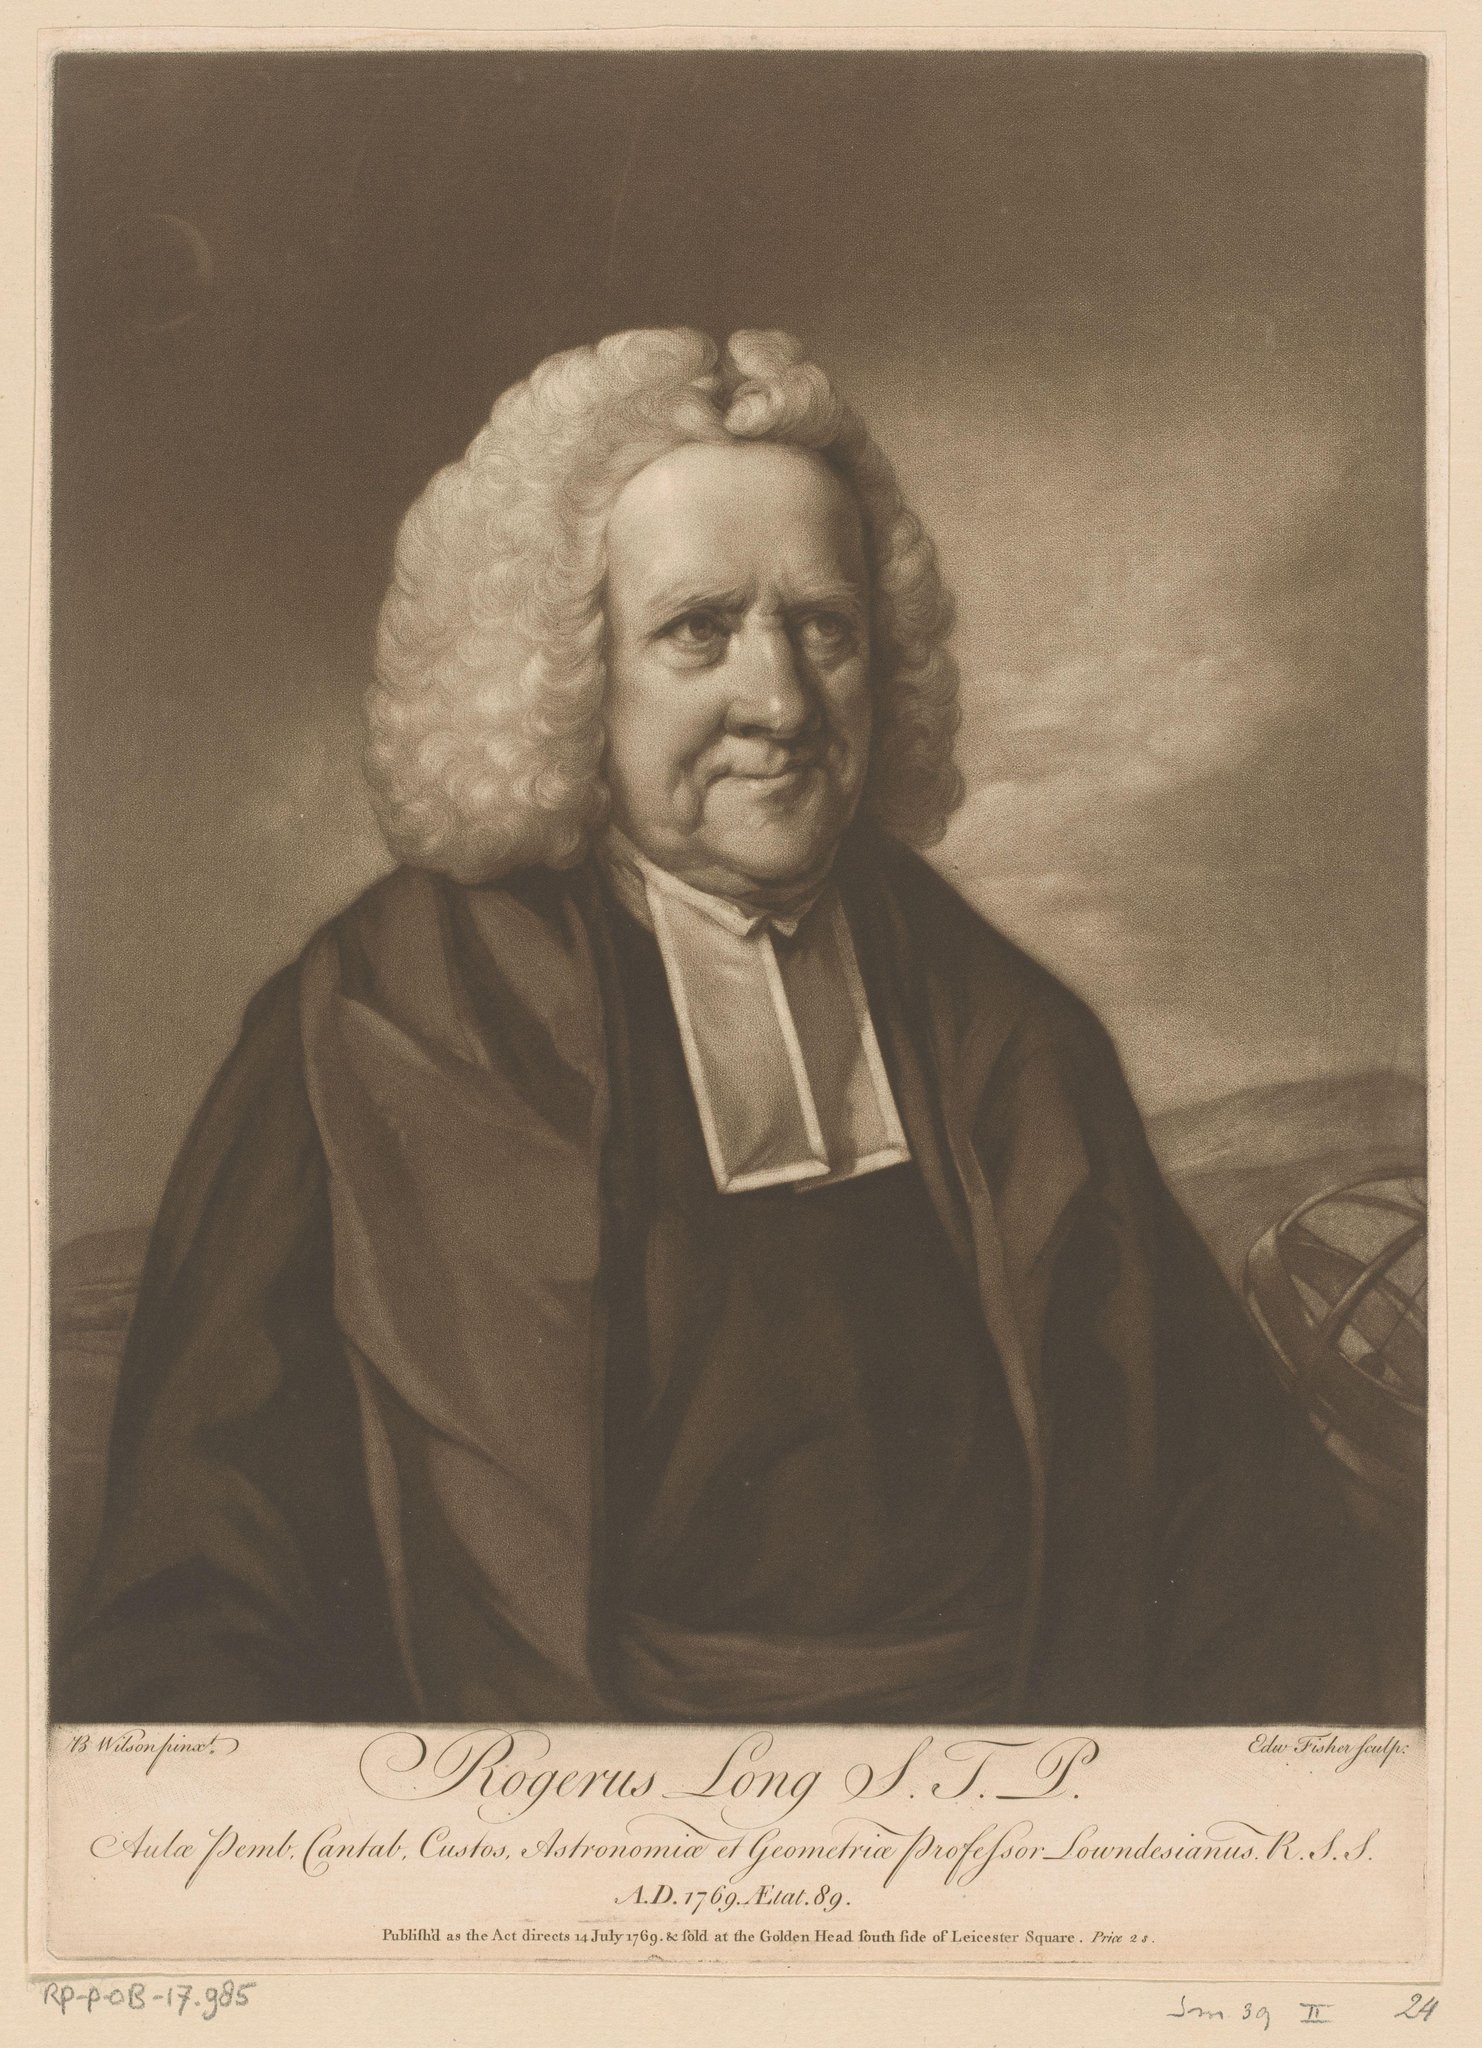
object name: print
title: Rogerus Long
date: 1707-1769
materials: paper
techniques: mezzotint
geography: london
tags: astronomy (and cosmography) (+ portrait of scholar, scientist), historical persons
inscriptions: collector's mark: Lugt 240